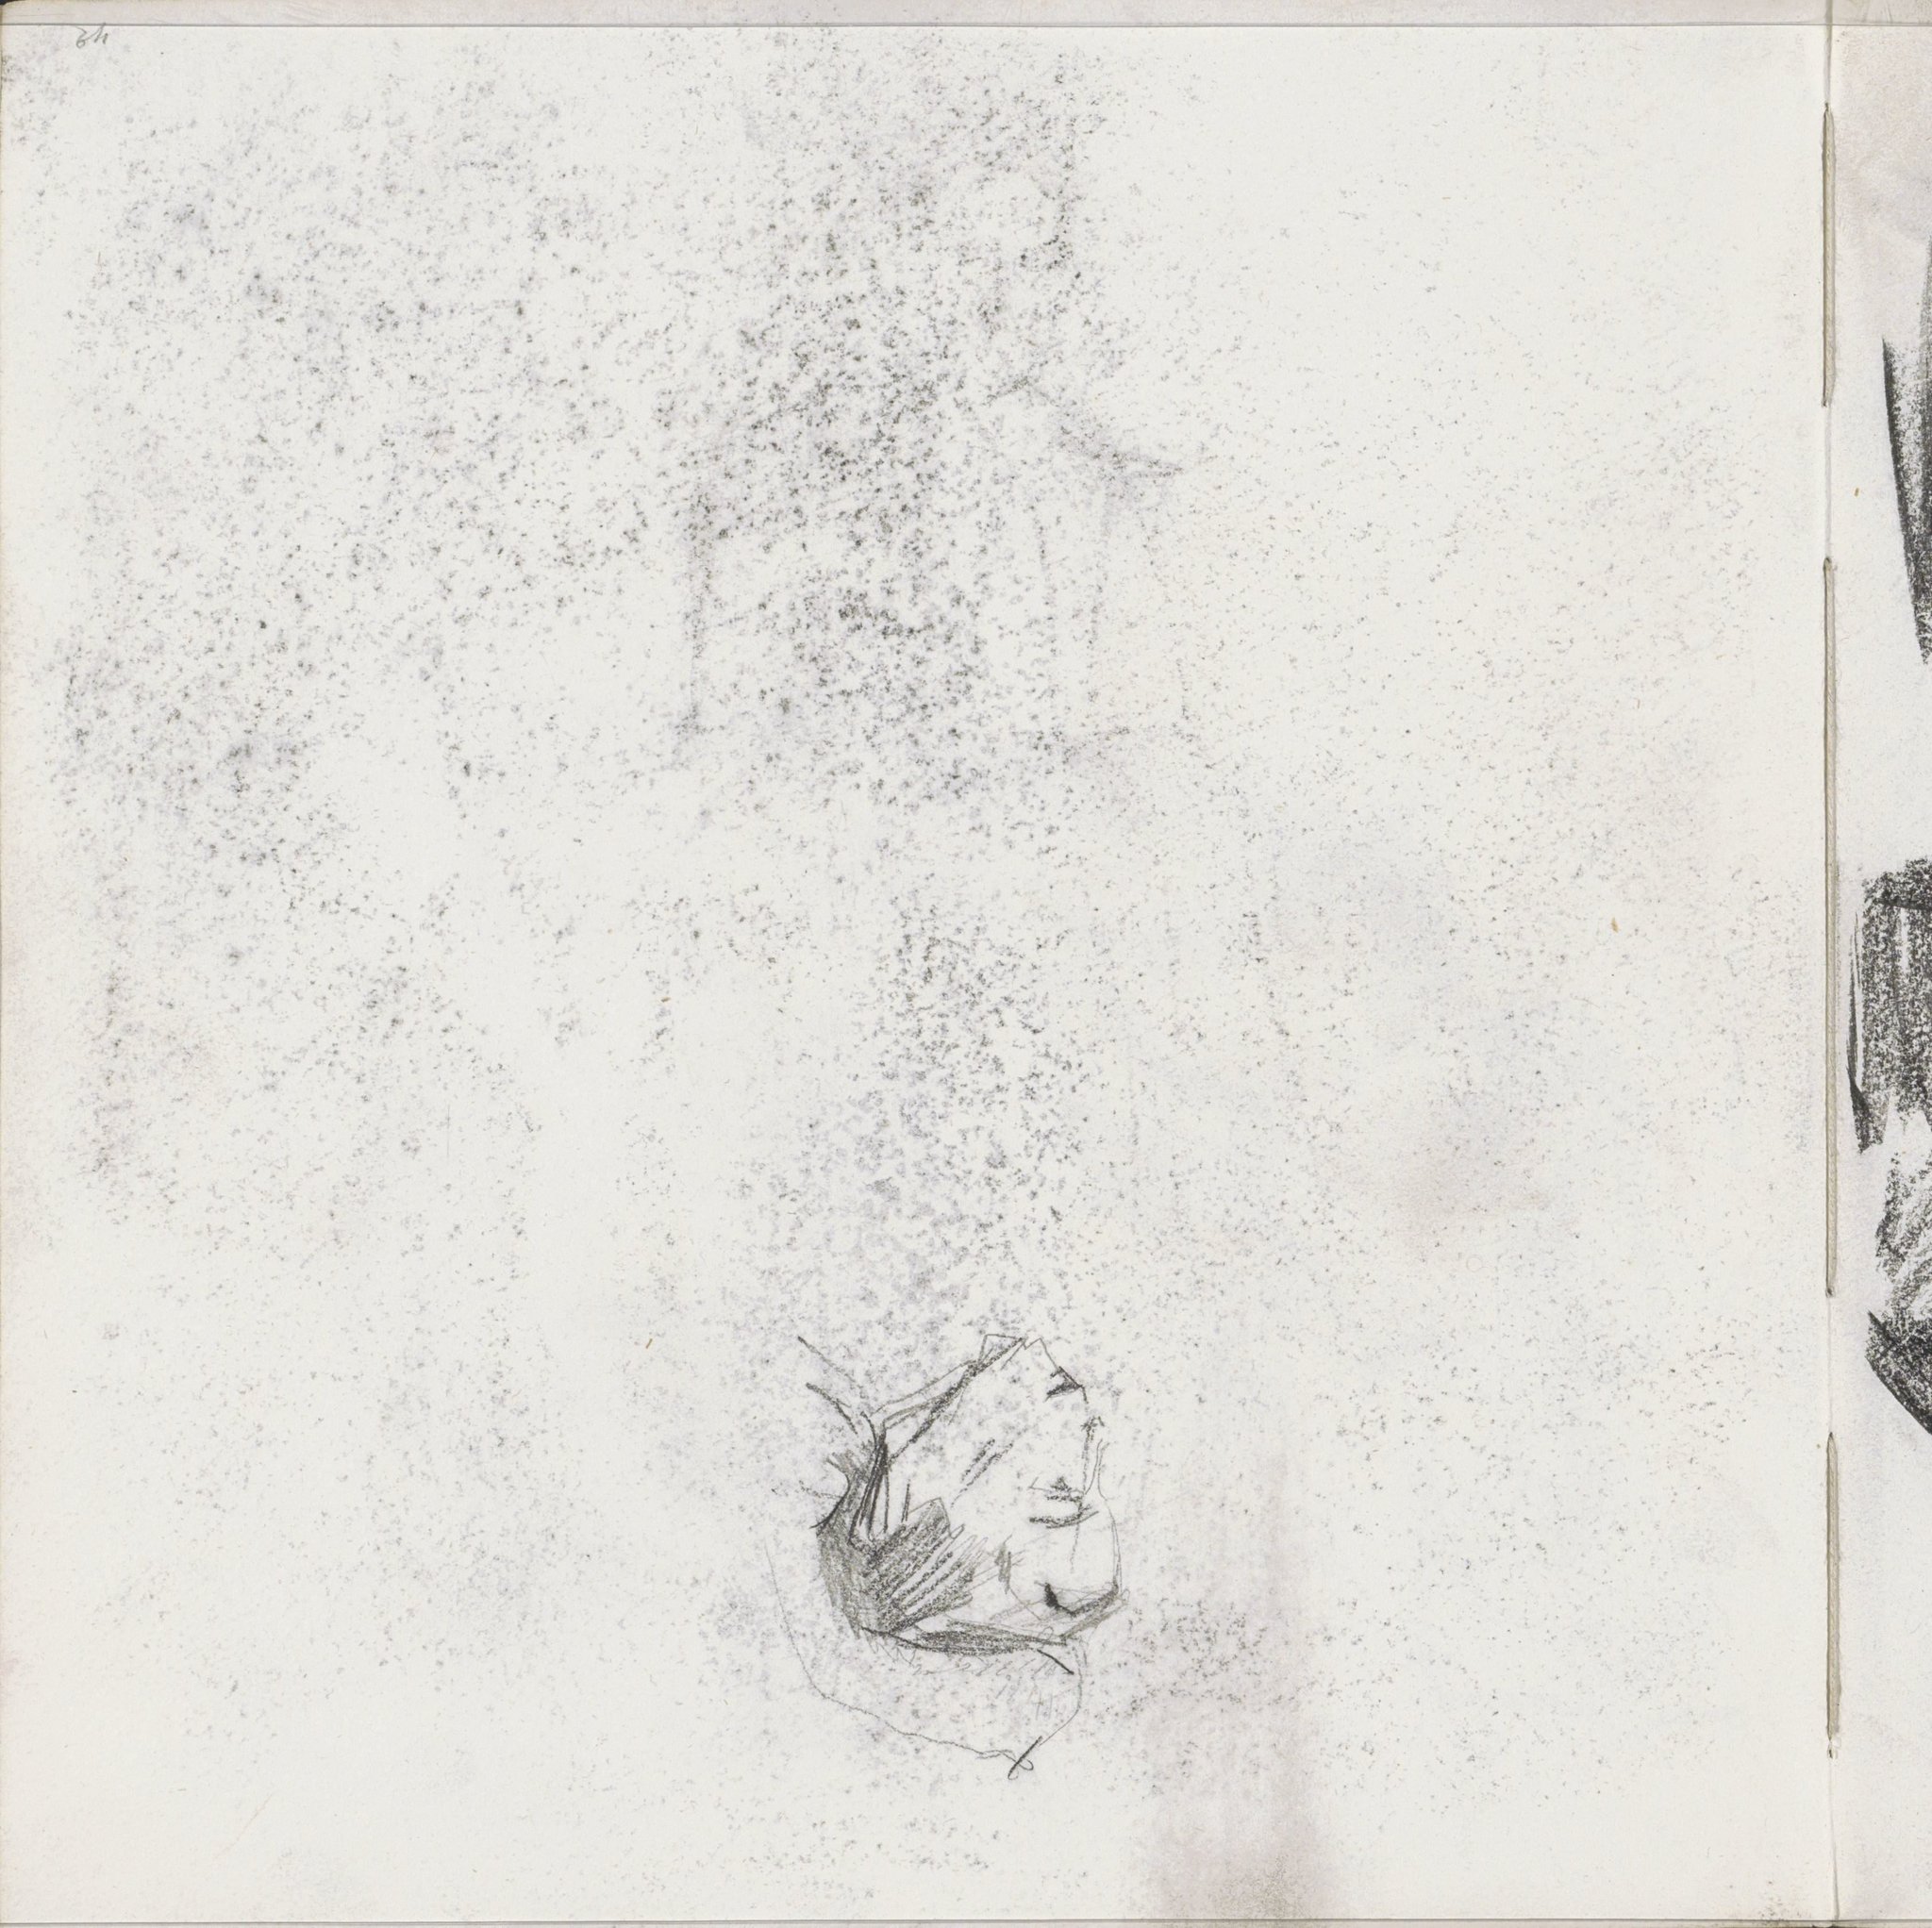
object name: sketchbook leaf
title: Vrouwenhoofd, in profiel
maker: isaac israels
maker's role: draughtsman, painter, print maker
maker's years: 1865-1934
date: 1875-1934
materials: chalk, paper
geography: the hague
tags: head (human) - aa - female human figure (+ sideview, profile)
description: Blad 15 verso uit schetsboek IX met 28 bladen.